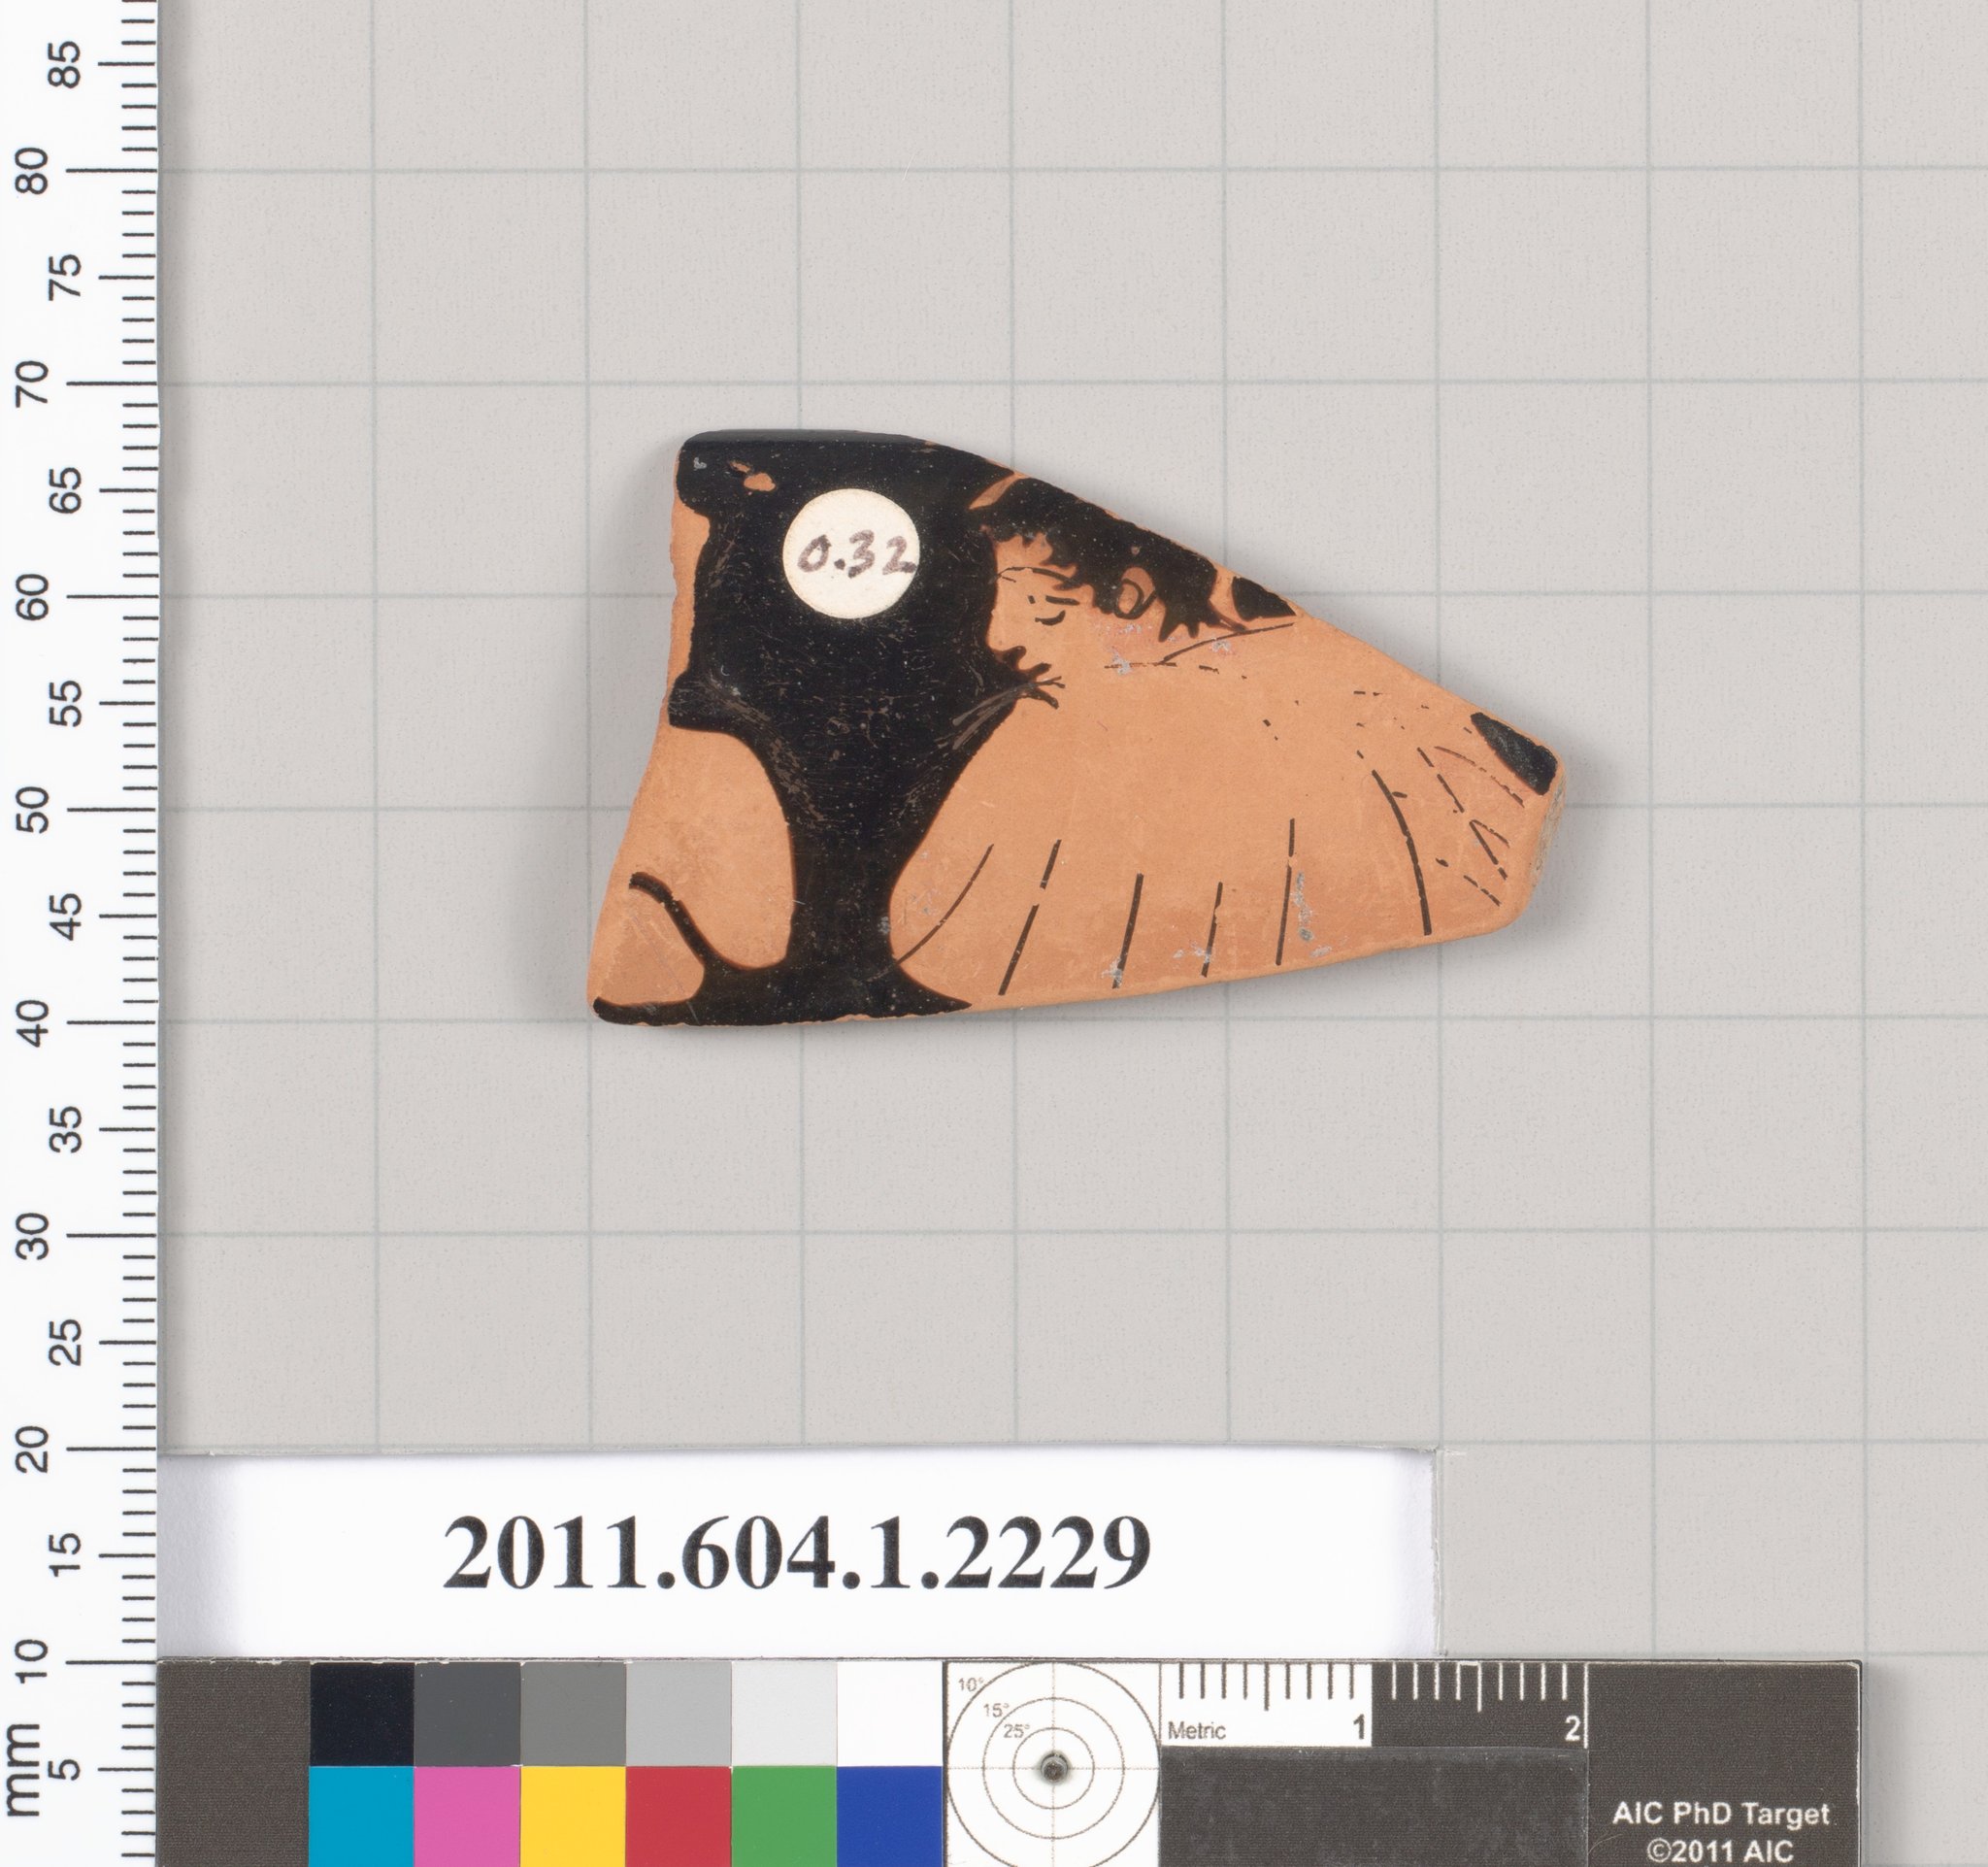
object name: kylix fragment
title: Terracotta rim fragment of a kylix (drinking cup)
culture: greek, attic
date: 475-451 BCE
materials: terracotta